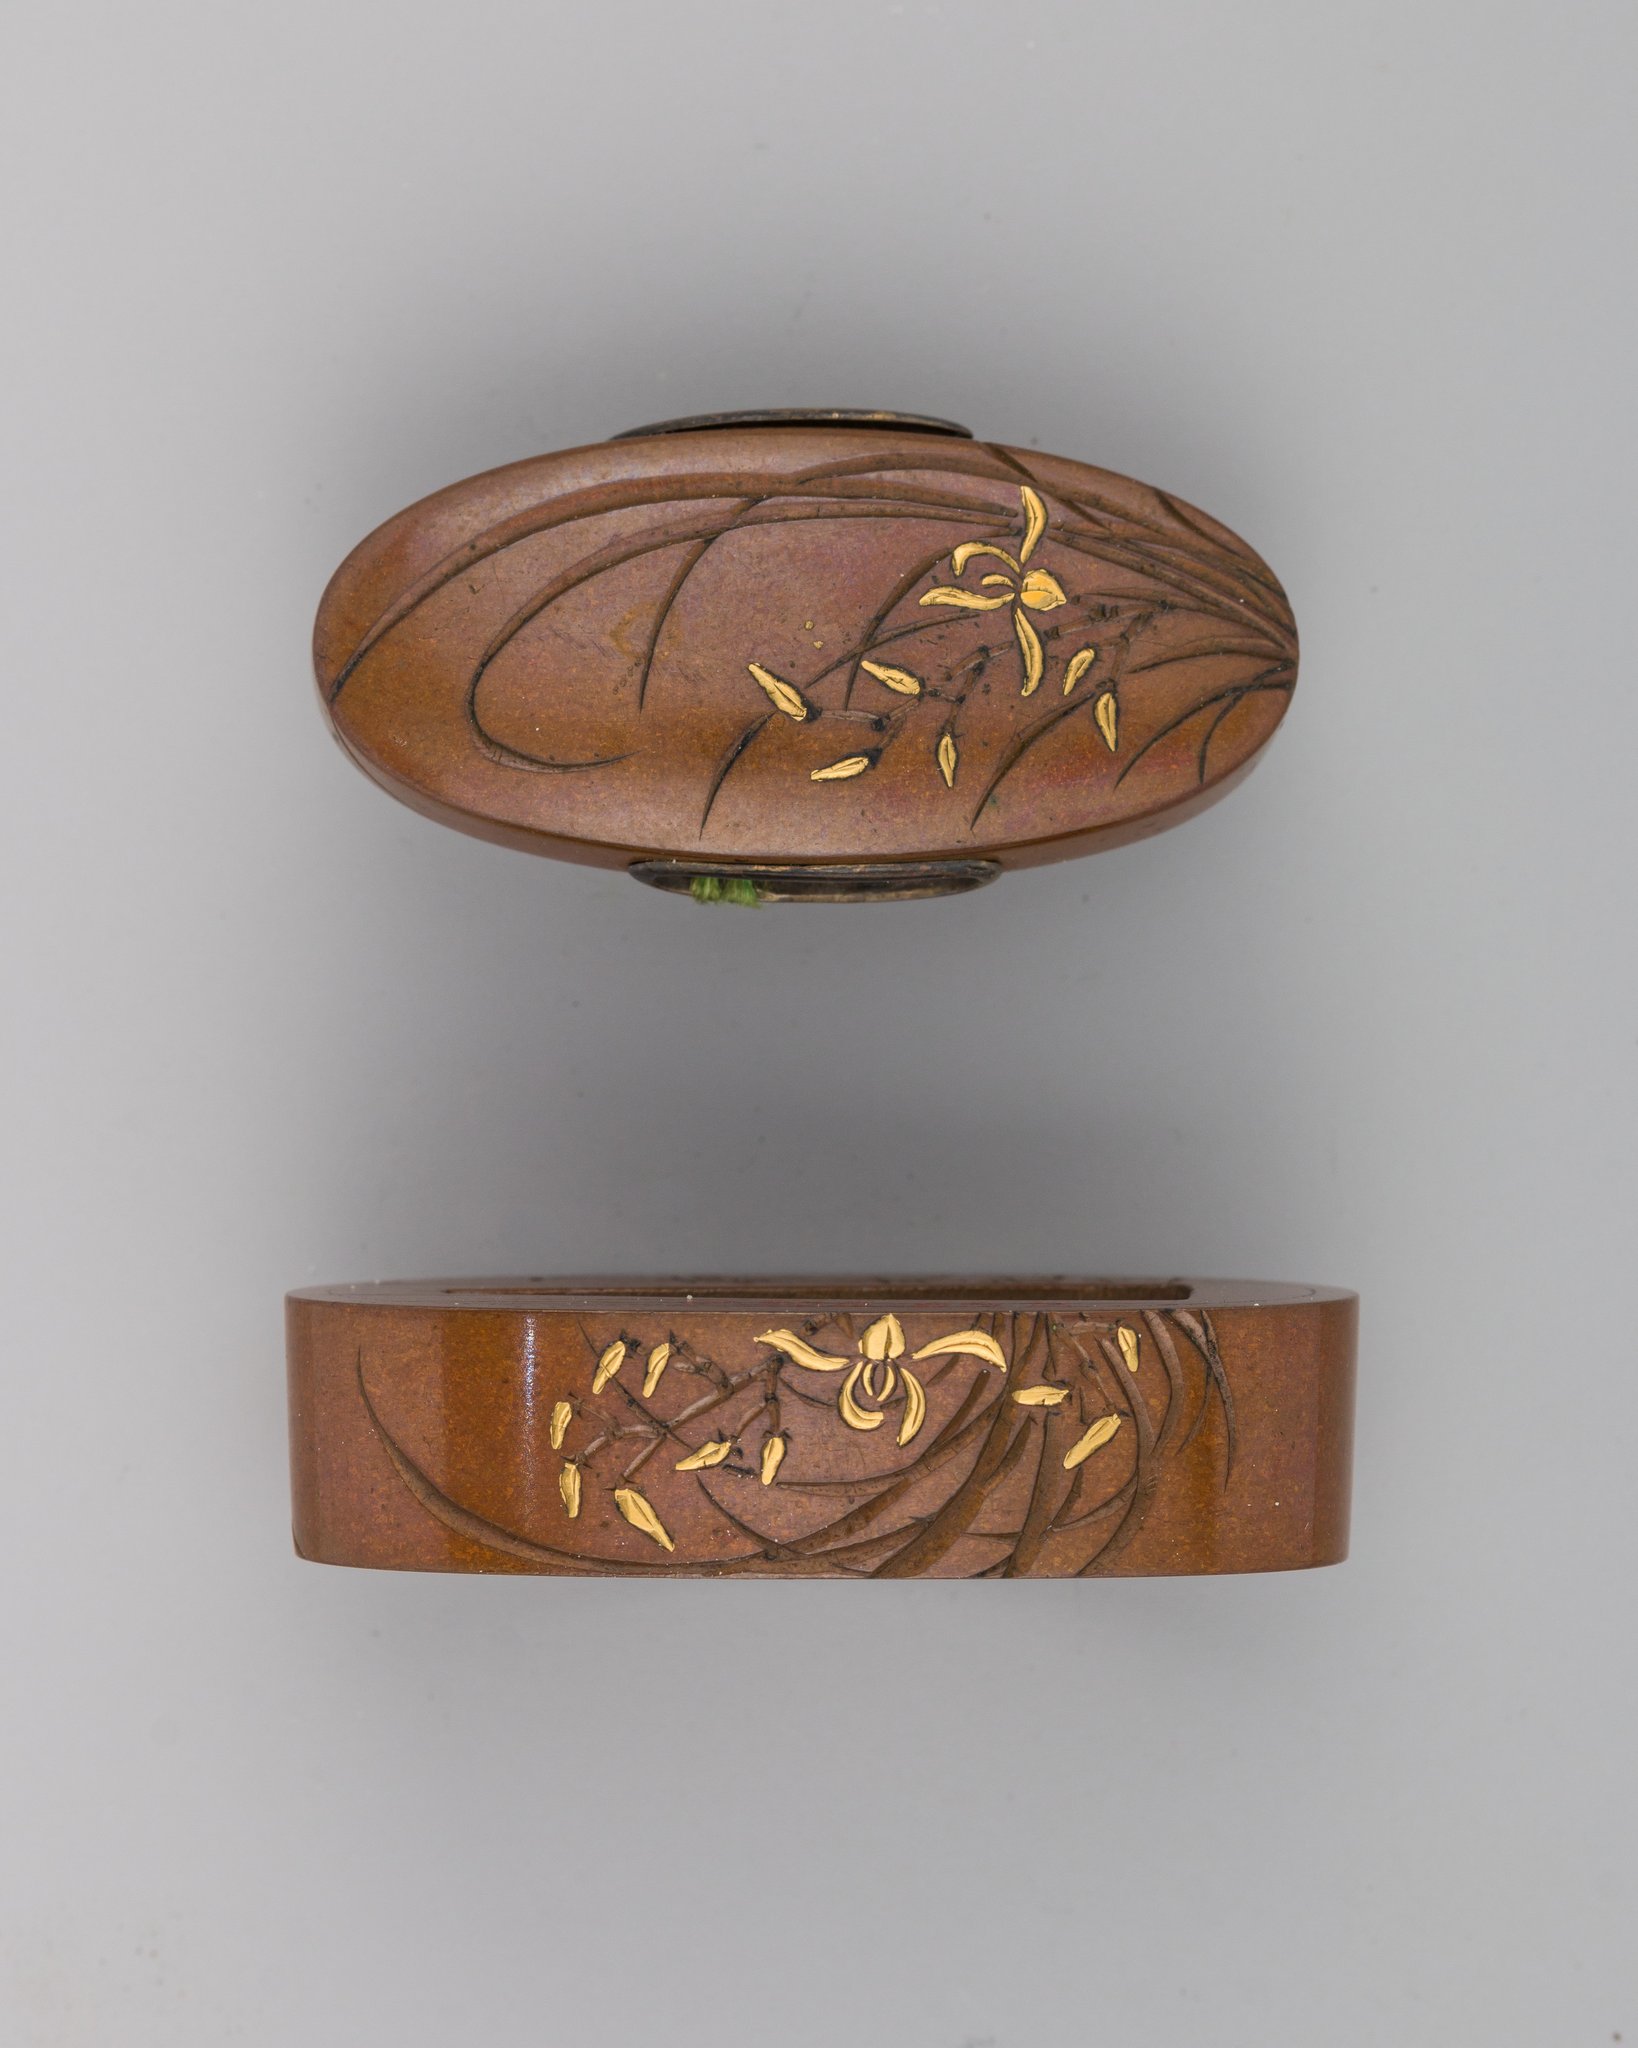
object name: sword hilt collar and pommel fuchigashira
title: Sword-Hilt Collar and Pommel (Fuchigashira)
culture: japanese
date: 1801-1900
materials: copper, gold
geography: japan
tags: leaves